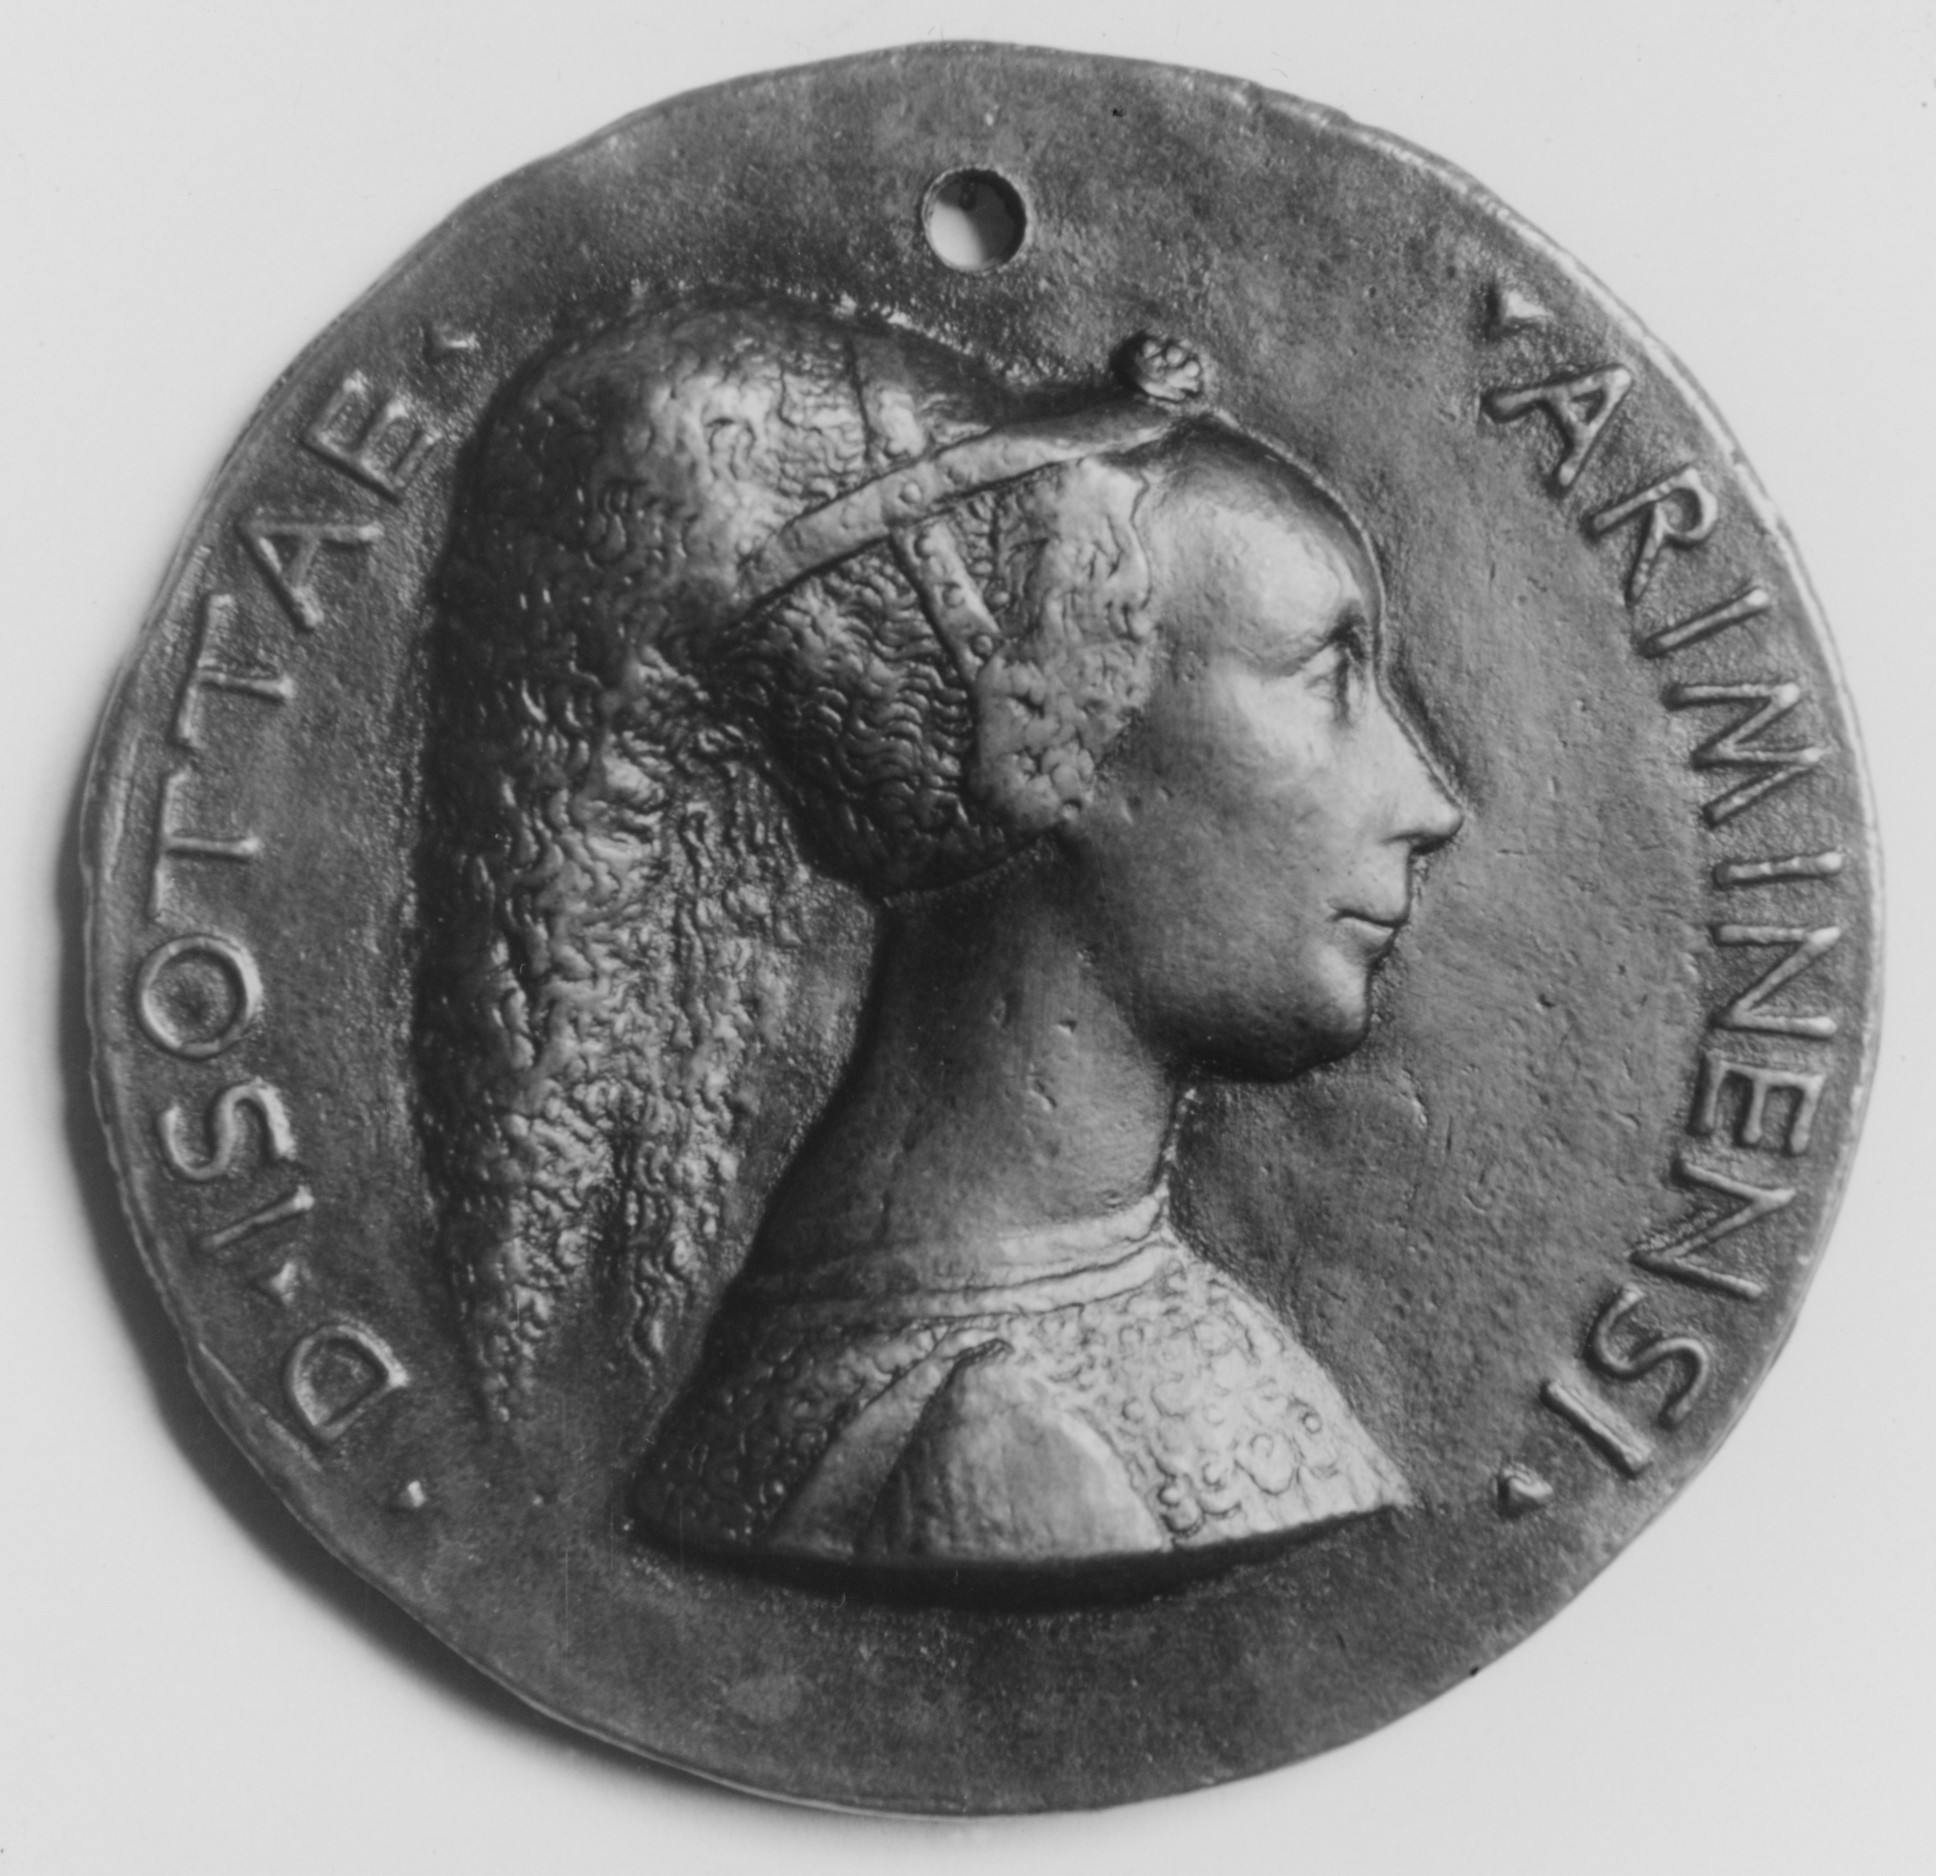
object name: medal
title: Isotta degli Atti of Rimini, d. 1470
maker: matteo de' pasti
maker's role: artist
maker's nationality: italian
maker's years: 1420-1467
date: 1446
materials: bronze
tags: profiles,women